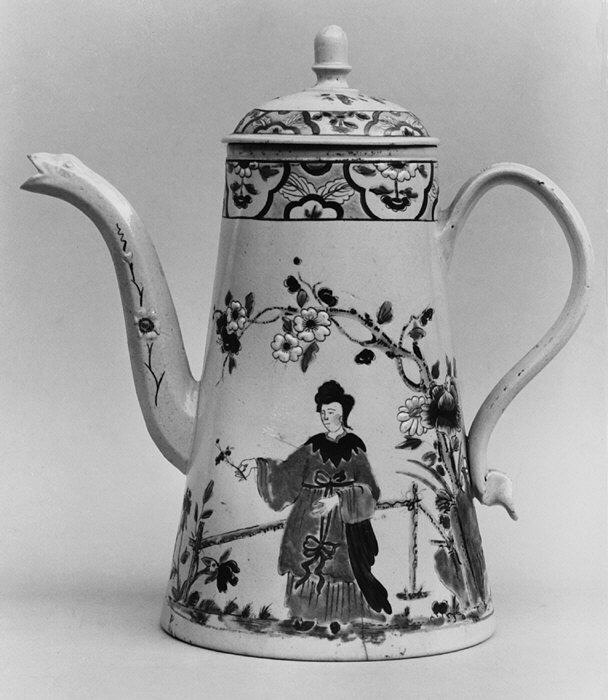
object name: coffeepot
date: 1750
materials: stoneware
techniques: salt glaze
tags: women,flowers